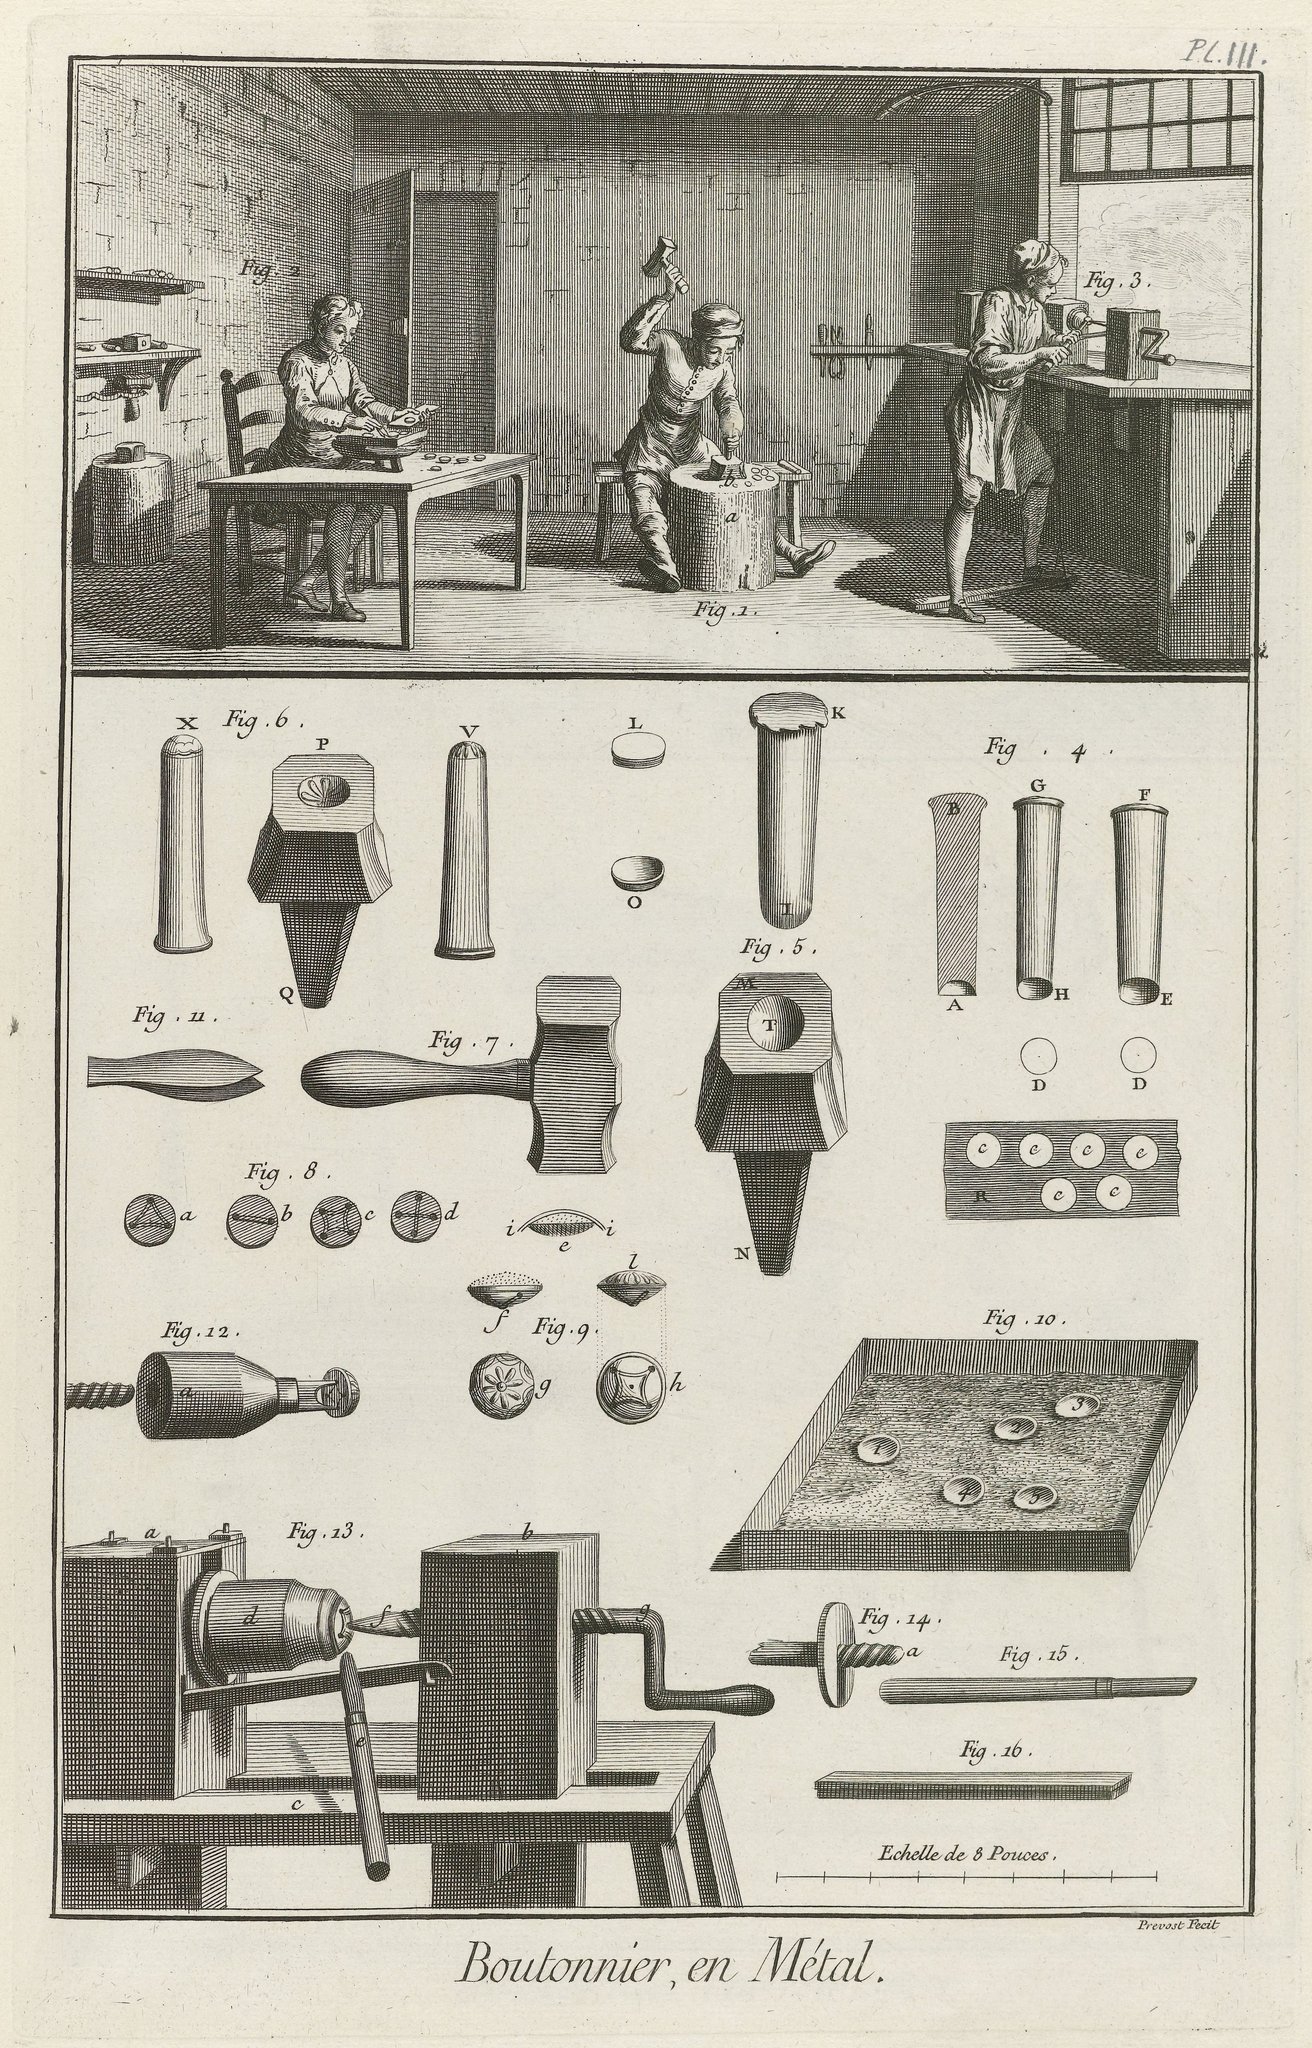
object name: book illustration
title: Boutonnier, en Métal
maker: prevost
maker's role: print maker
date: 1751-1772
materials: paper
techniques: engraving, letterpress printing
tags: button (+ other materials used for clothes), fashion plates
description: Over het maken van metalen knopen: Bovenaan gezicht in werkplaats; daaronder verschillend soort gereedschap en voorbeelden van knopen. Uit Encyclopédie ou dictionnaire raisonné des sciences, des arts et des métiers door Denis Diderot en Jean Le Rond d'Alembert, Parijs, 1751-1772.